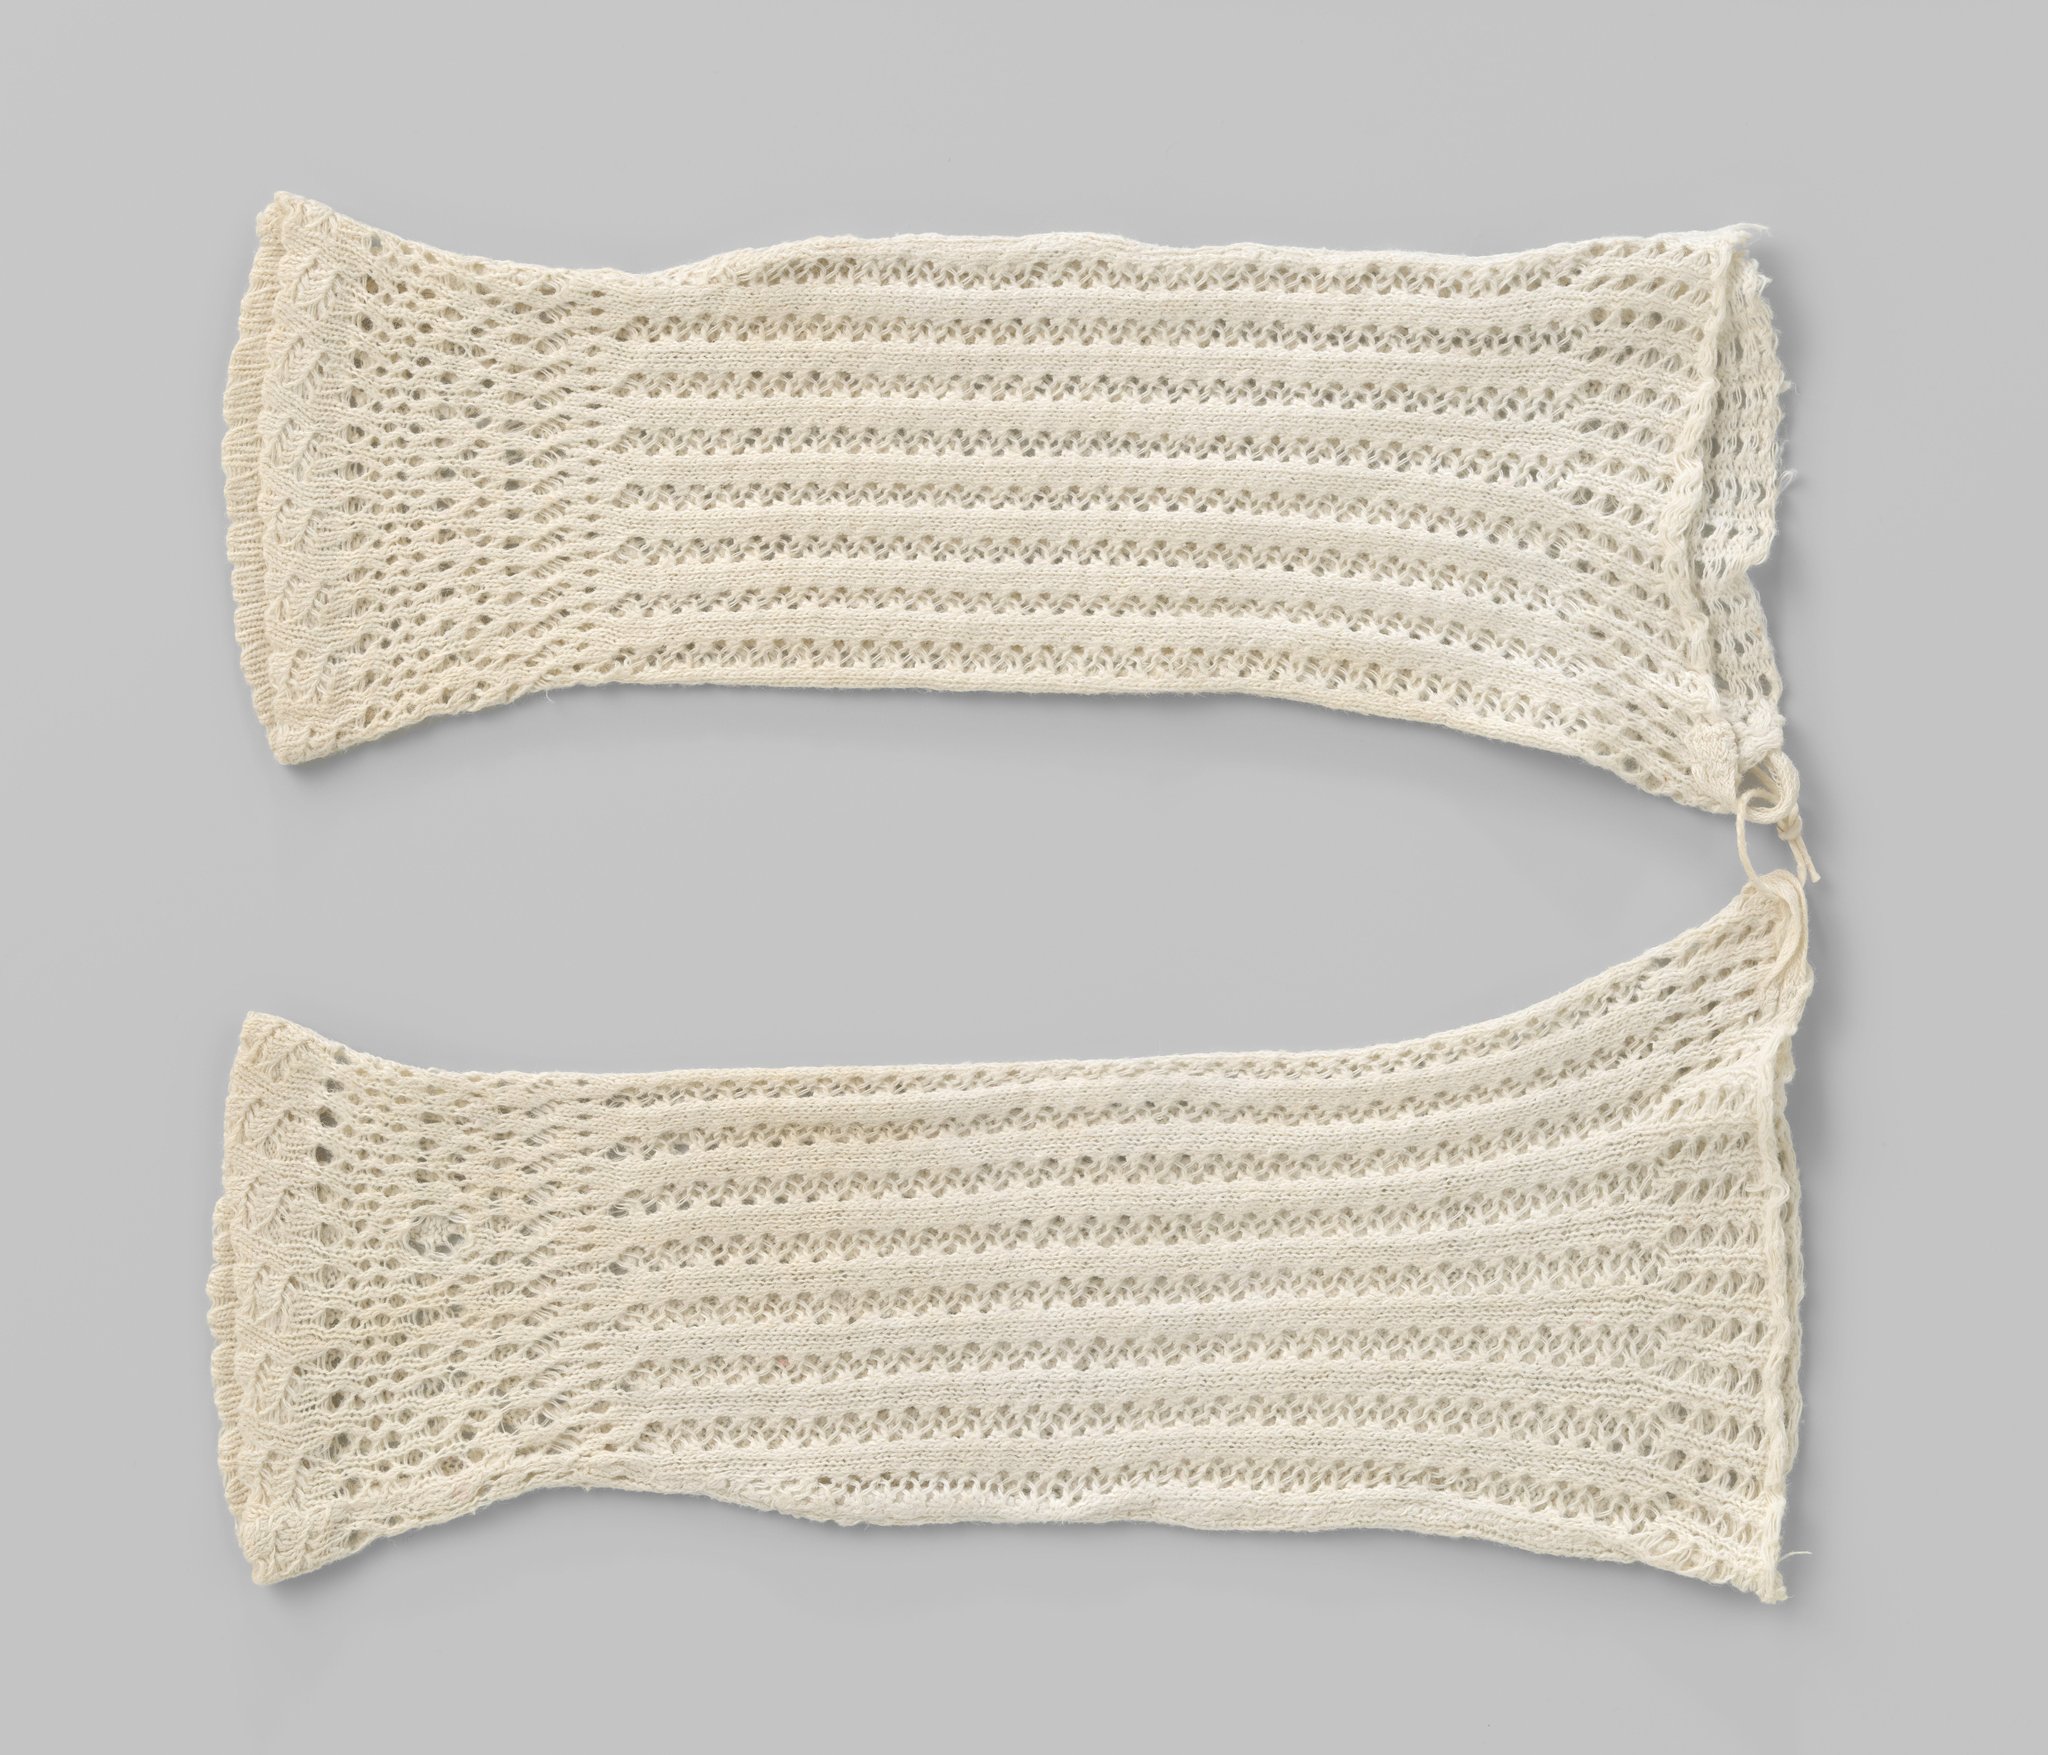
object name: sleeve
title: Wit gebreide kindermouw met ajourwerk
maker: Anonymous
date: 1800-1899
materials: textile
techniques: embroidery, knitting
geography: netherlands